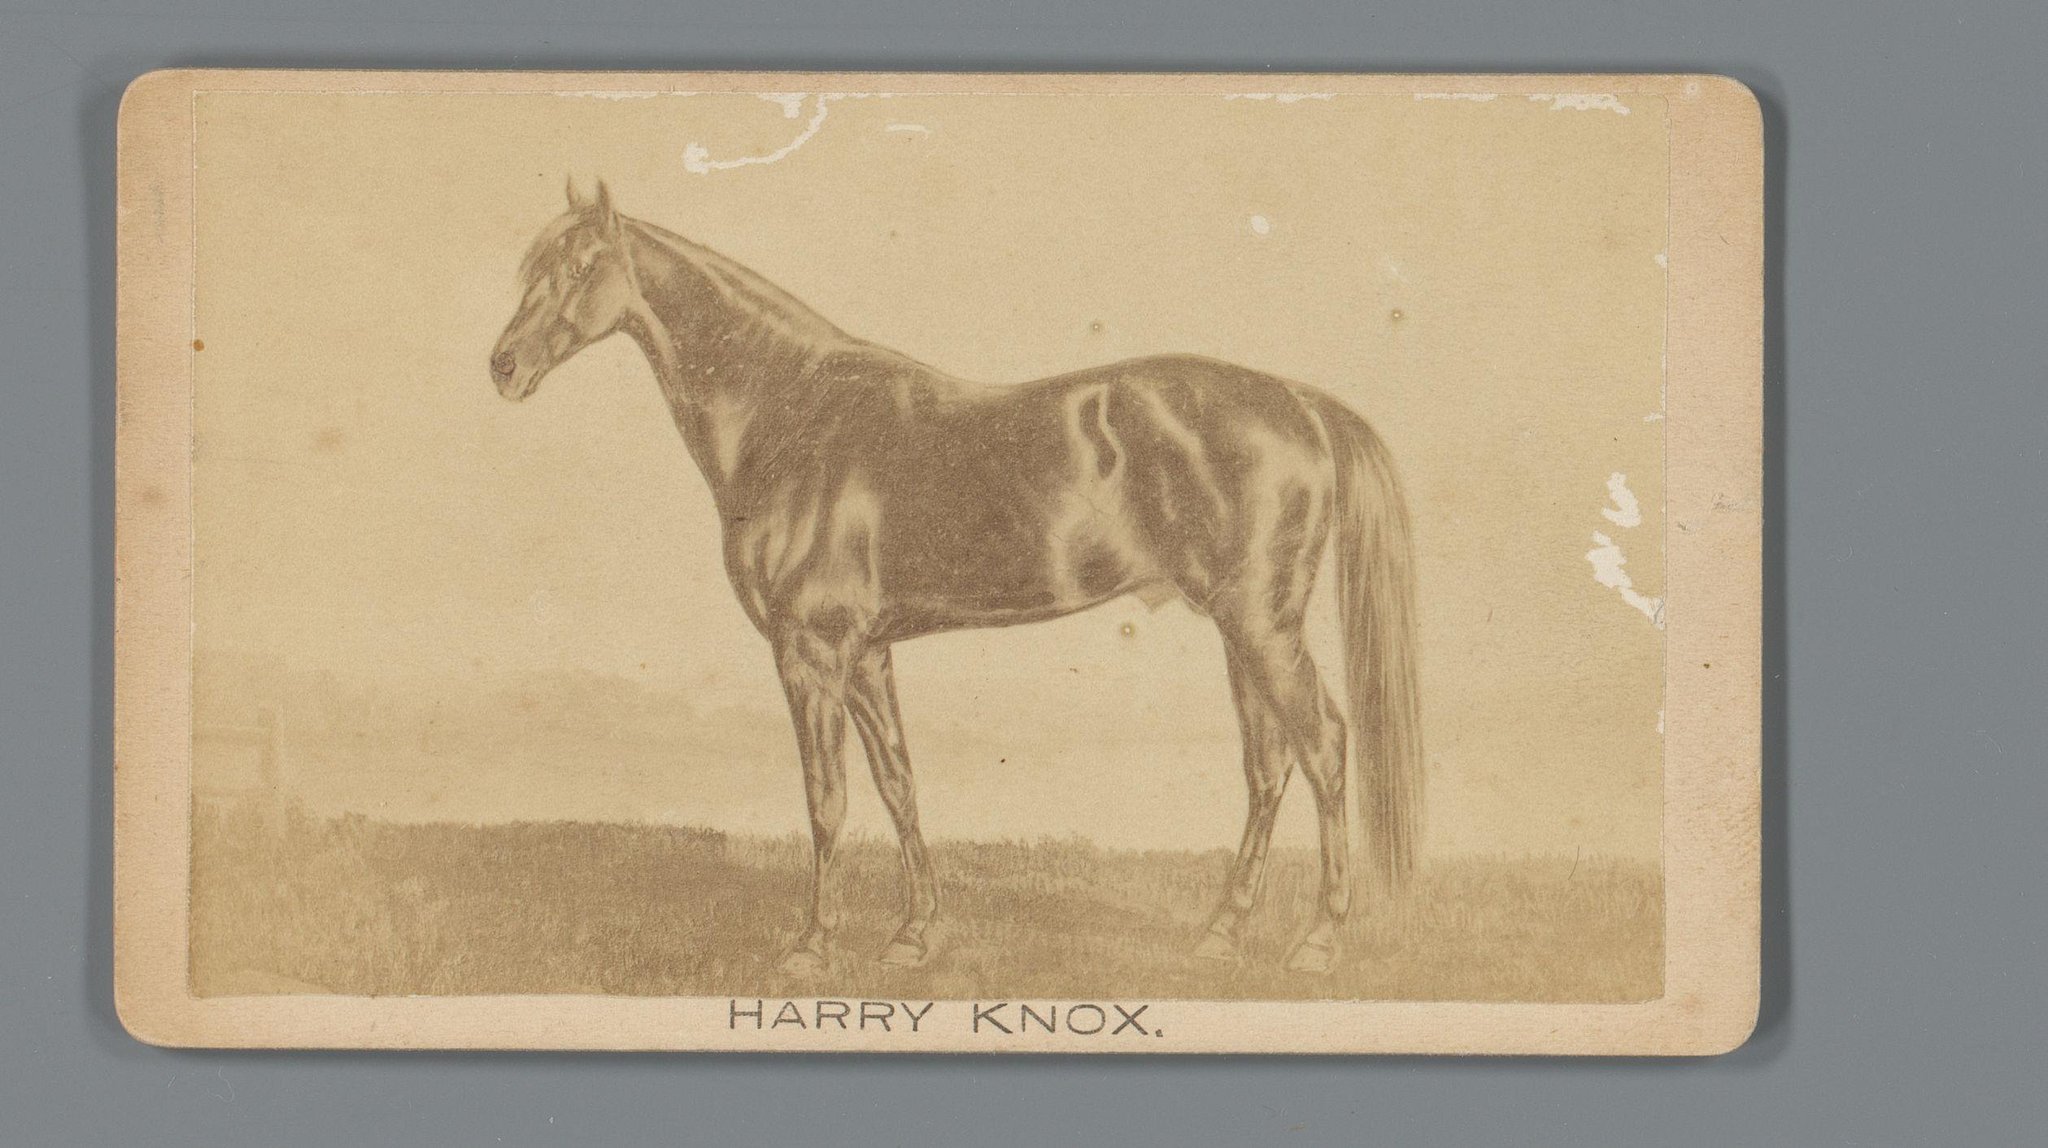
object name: photograph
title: Fotoreproductie van een getekend paard genaamd Harry Knox aangeboden door F.N. Kimball in North Brighton, Massachusetts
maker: Anonymous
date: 1875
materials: cardboard, photographic support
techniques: albumen print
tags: advertising, horse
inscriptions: inscription: ‘Harry Knox./ Black Stallion (...)/ For further particulars, call on or address F.N. Kimball, North Brighton,/ March 1st, 1875.’